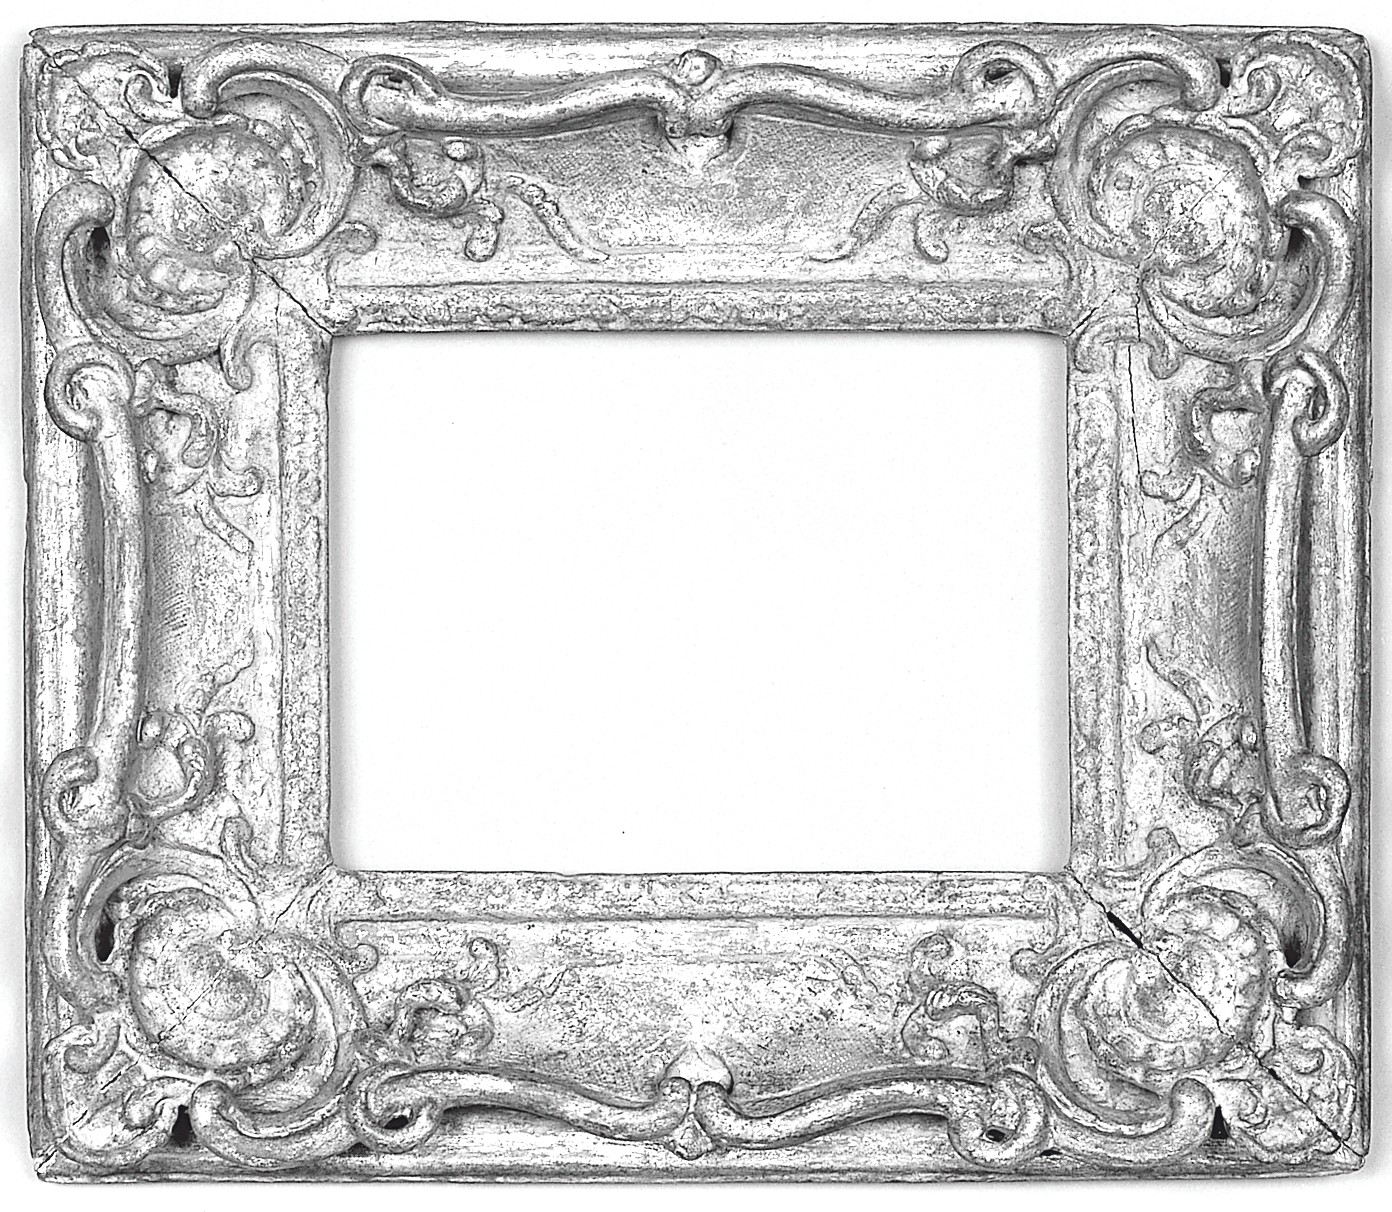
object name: frame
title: Swept frame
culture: french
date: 1750-1760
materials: wood